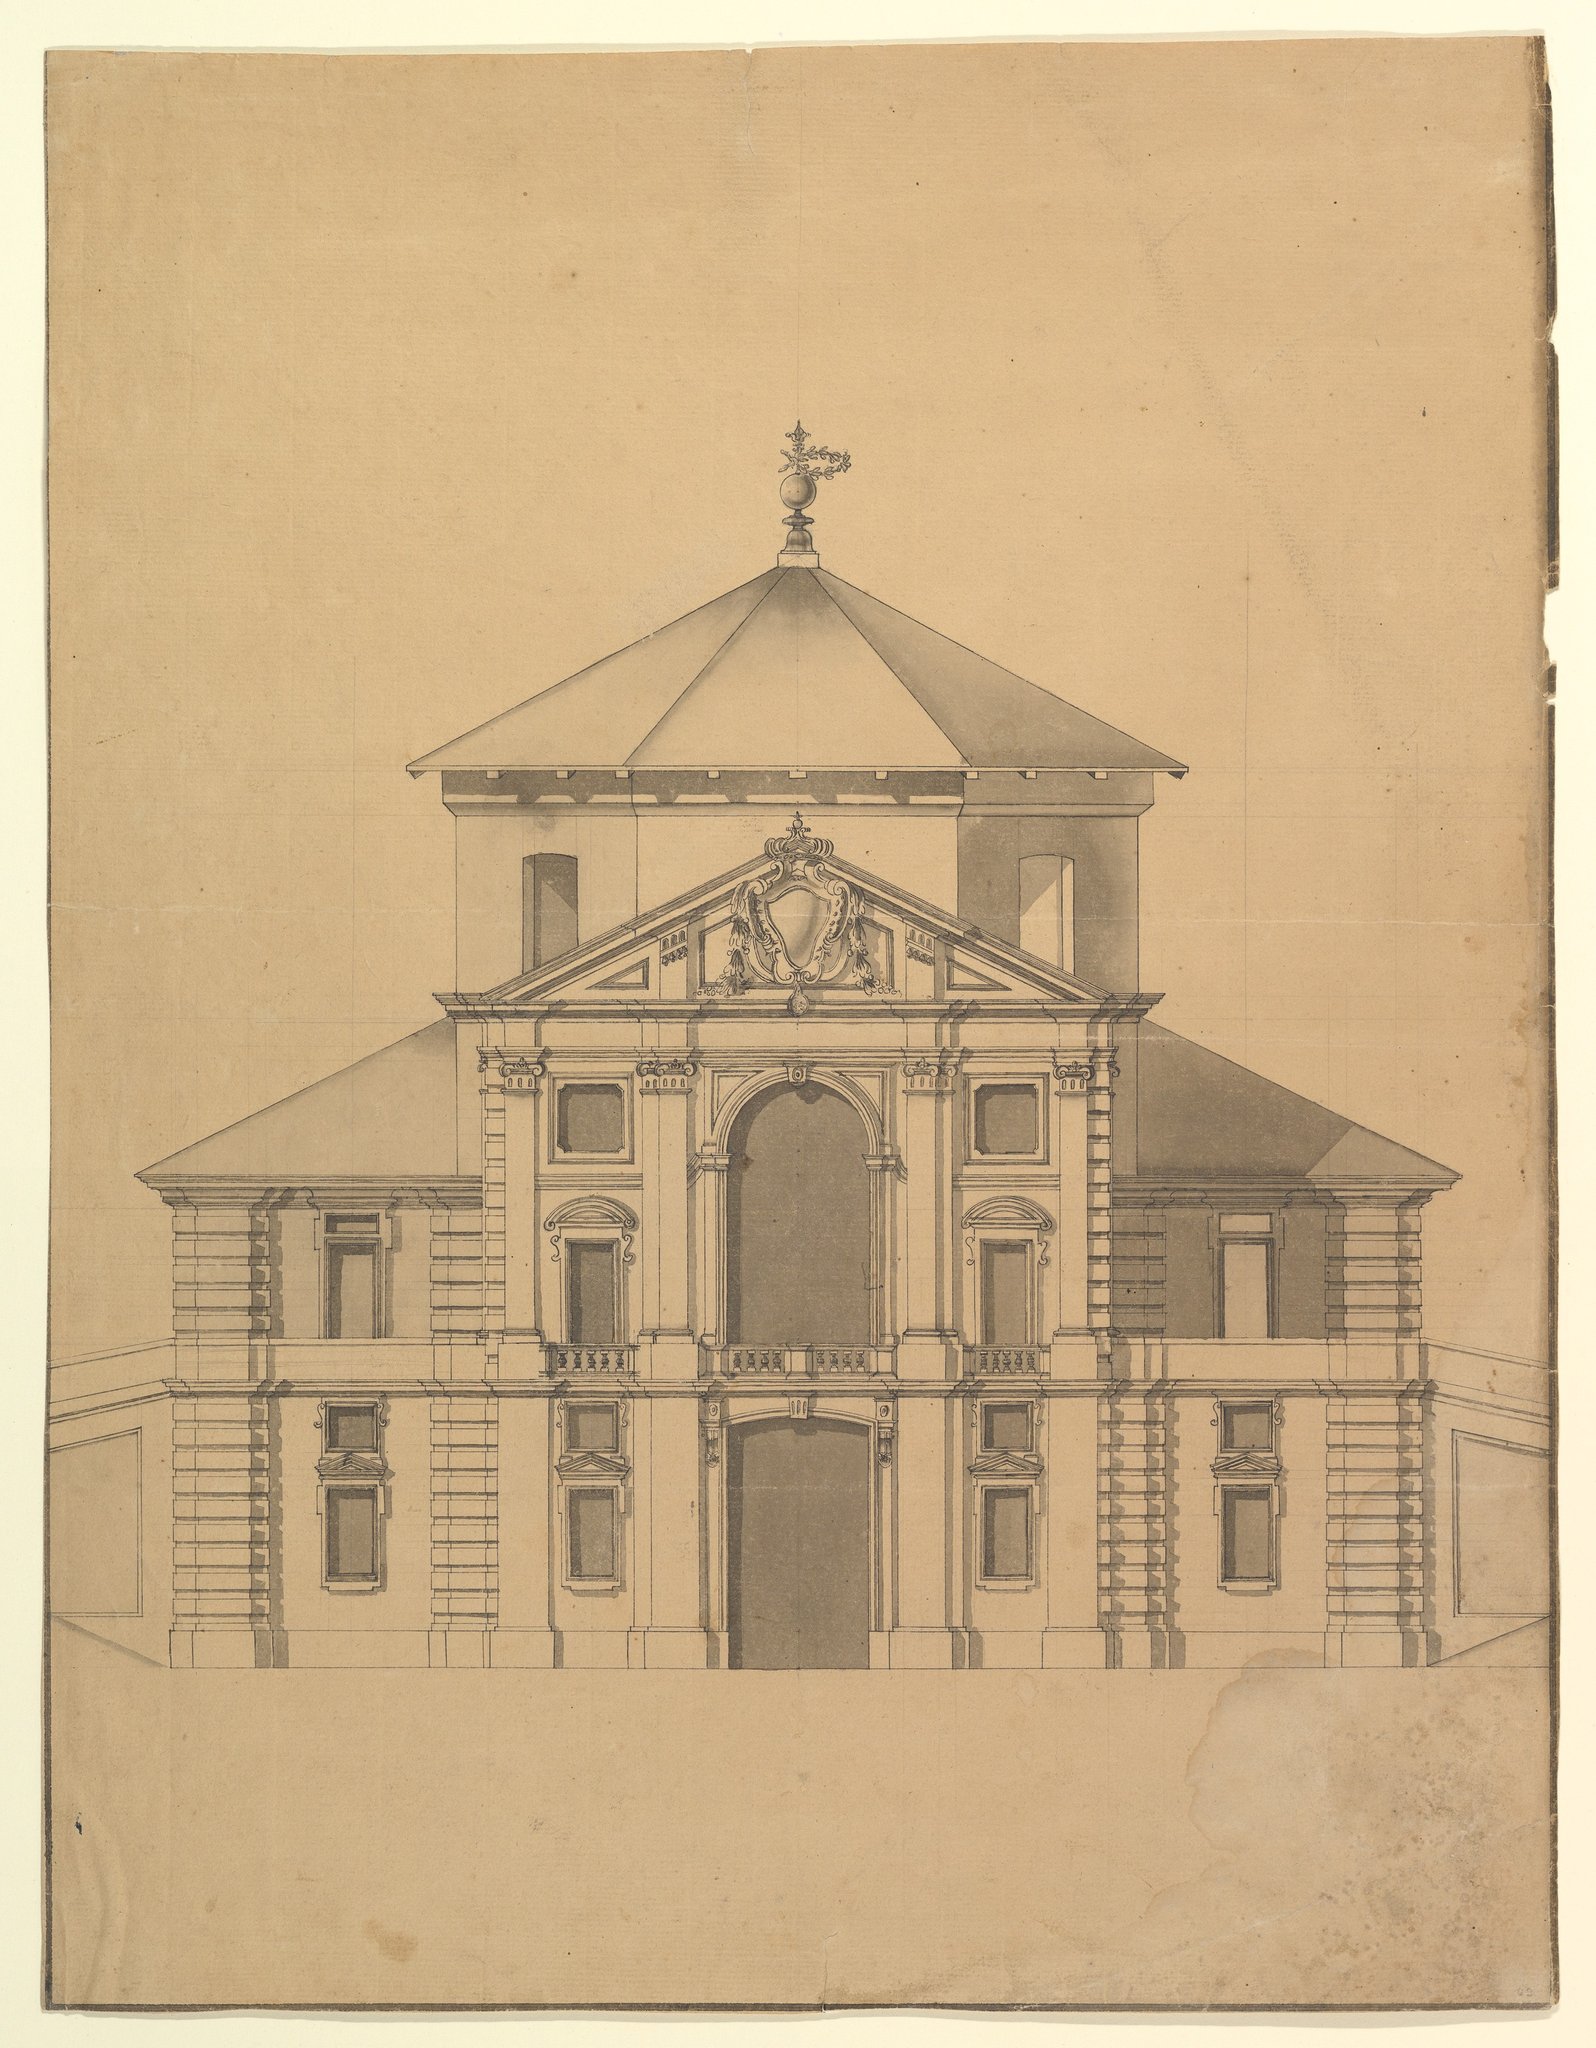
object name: drawing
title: Elevation for a Building with an Octogonal Cupola and two stoy Pendimenting Facades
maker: anonymous, italian, piedmontese, 18th century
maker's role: artist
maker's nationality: italian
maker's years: 1700-1800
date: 1700-1780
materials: graphite, ink, drawing material, paper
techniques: brush, pen, wash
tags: architecture,buildings